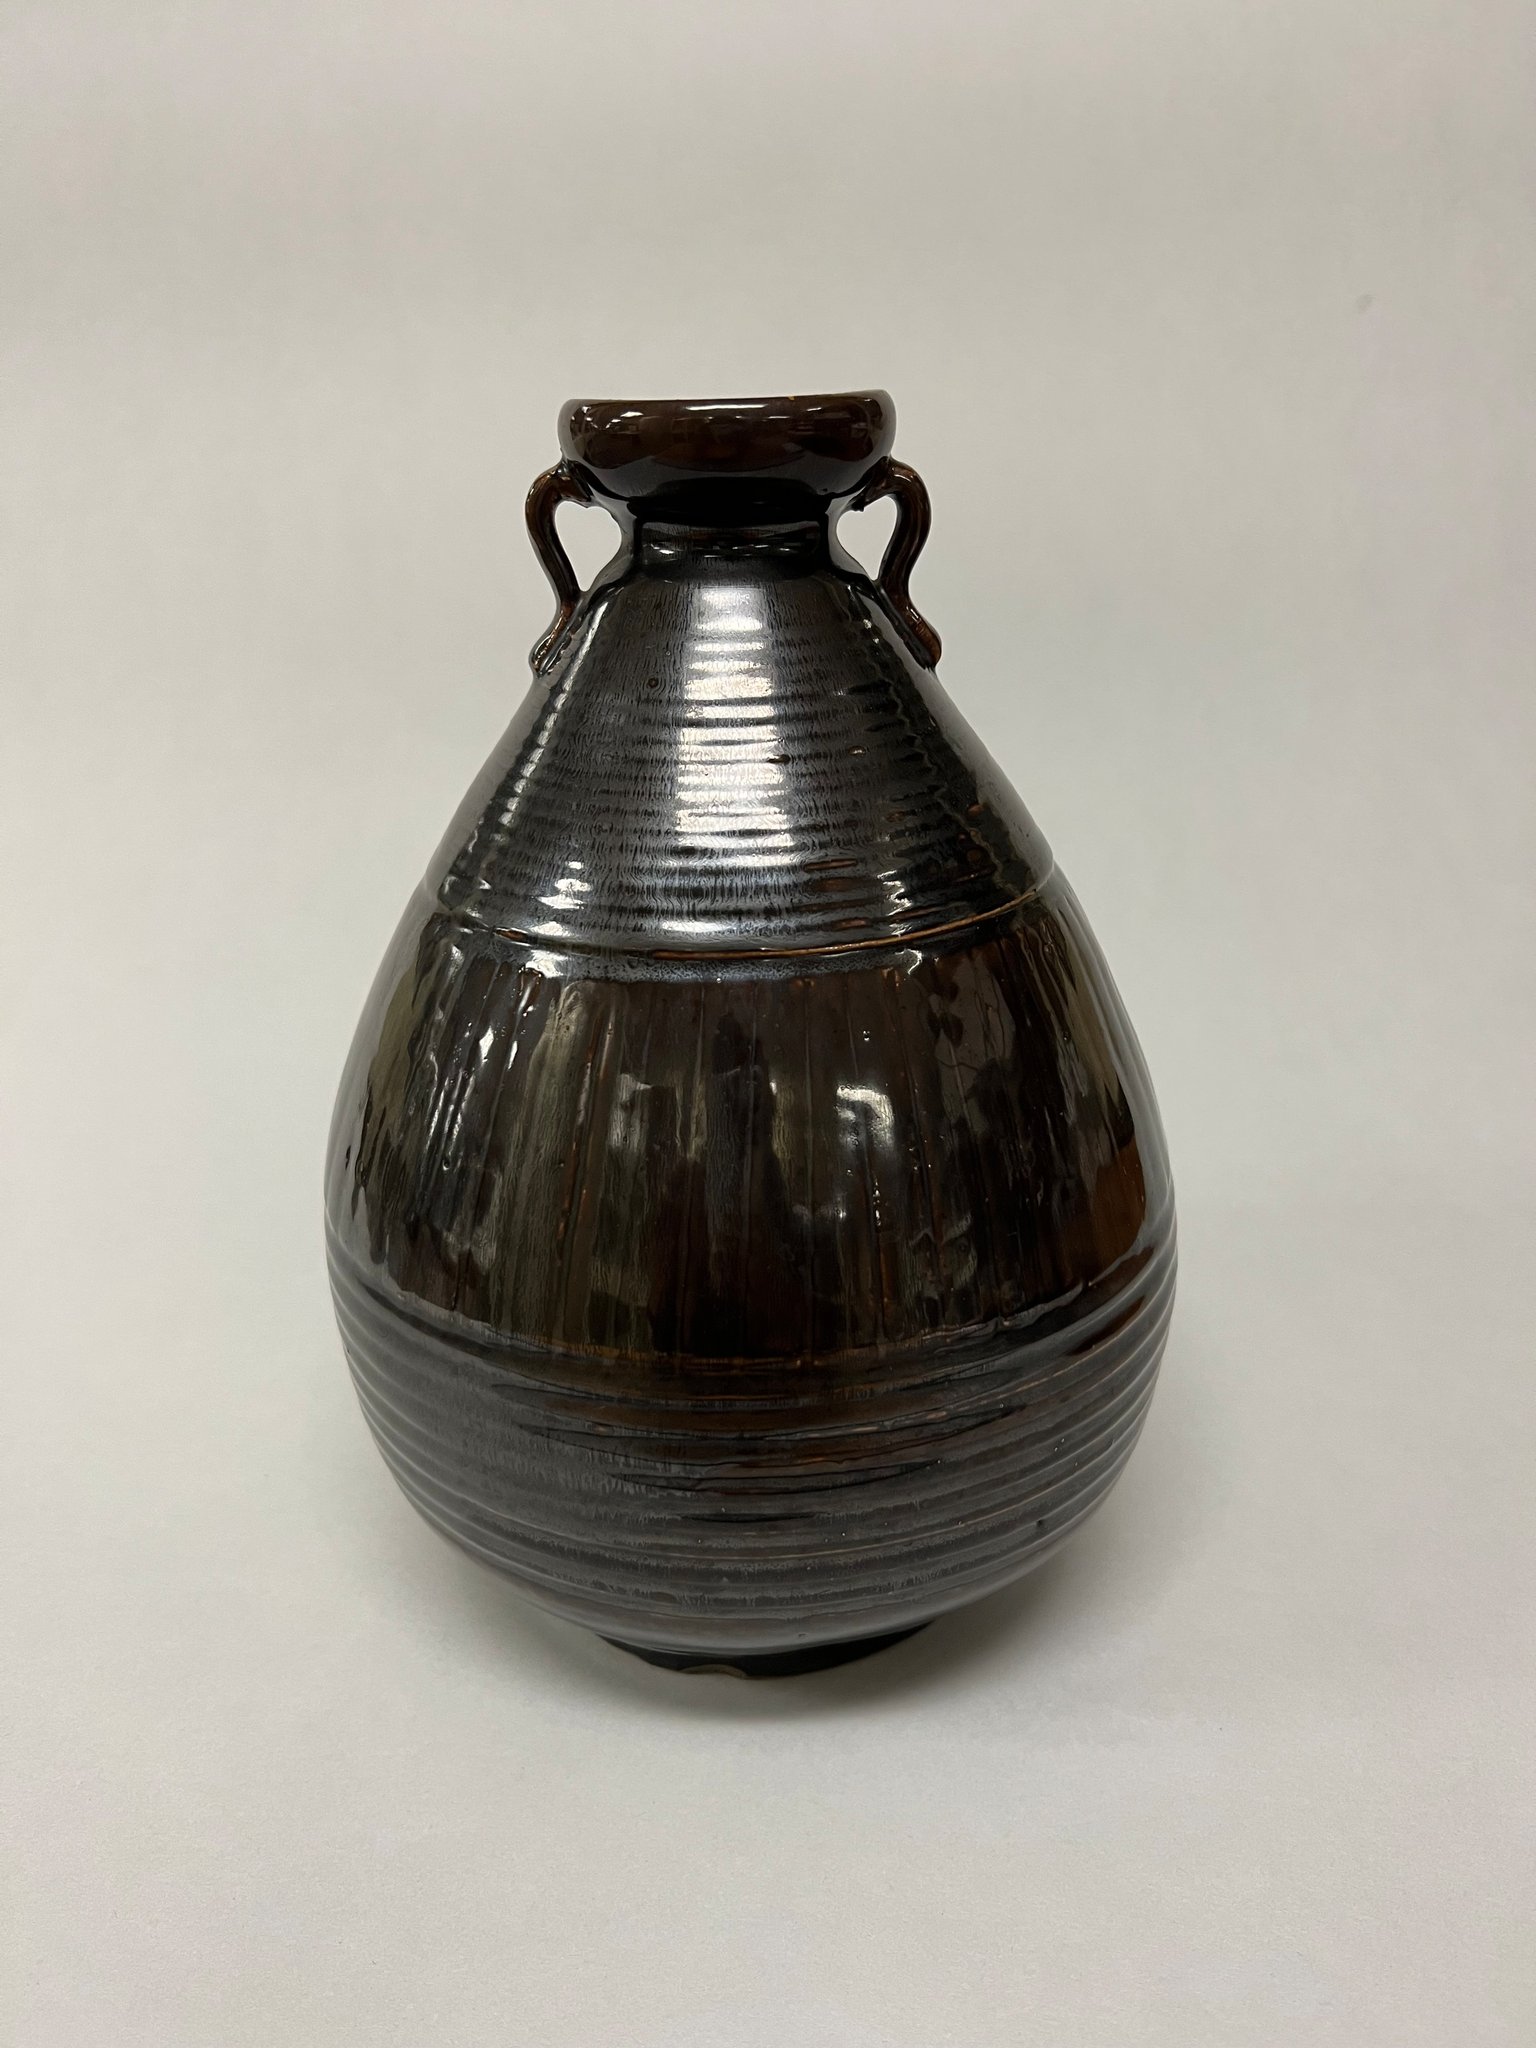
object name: jar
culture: japanese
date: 1801-1900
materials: clay, glaze